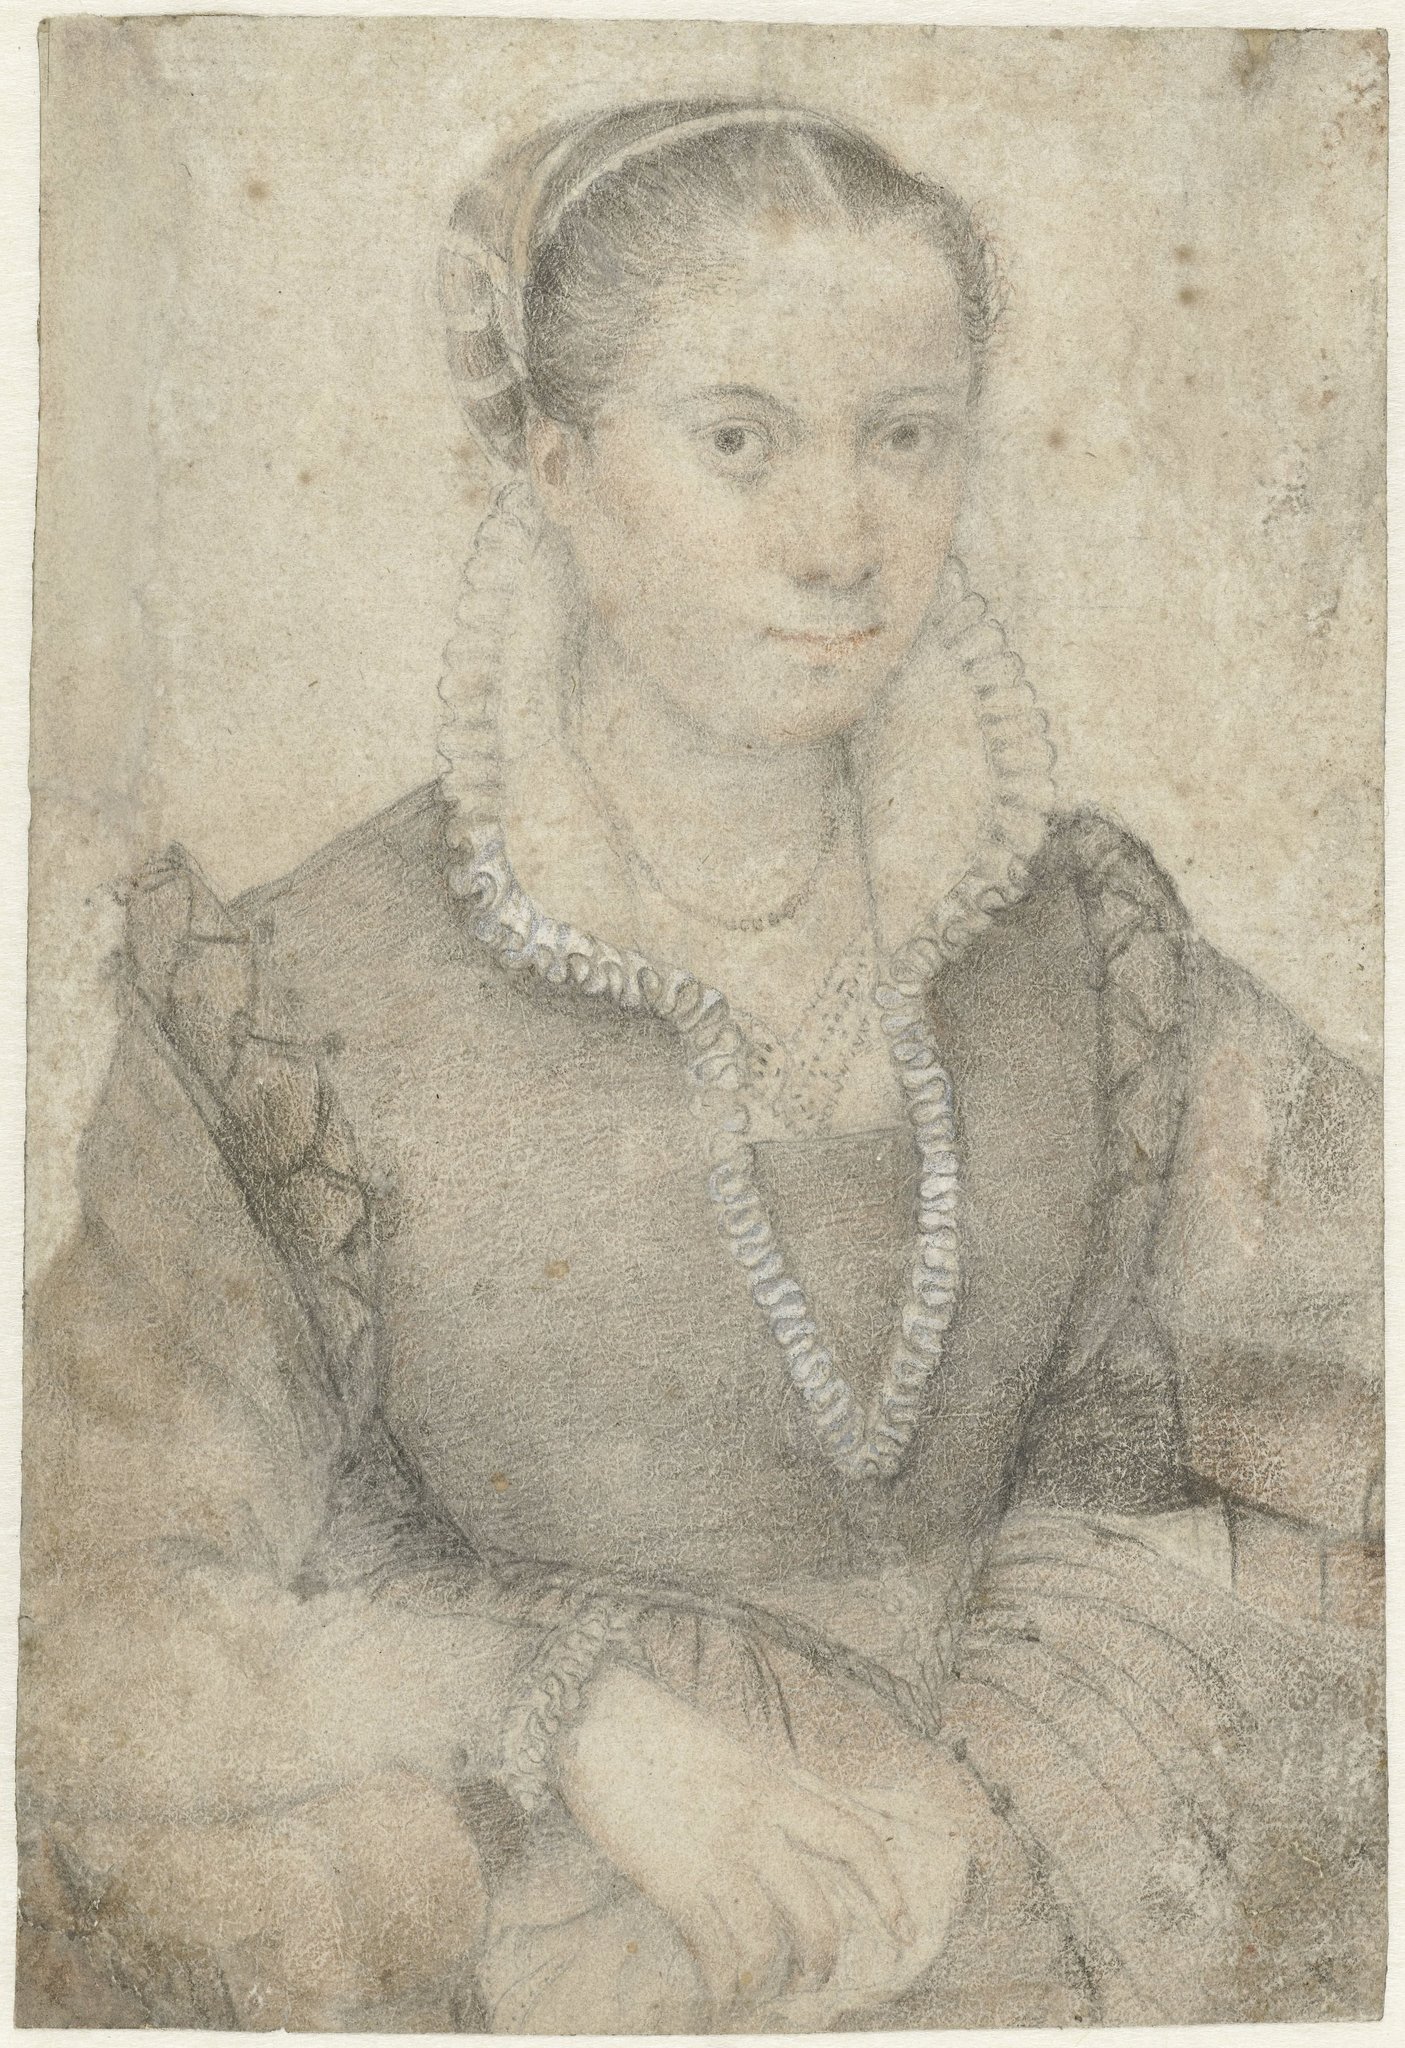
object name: drawing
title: Portret van dame, zittend naar rechts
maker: sofonisba anguissola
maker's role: draughtsman, painter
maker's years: 1527-1625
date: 1540-1626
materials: chalk, paper